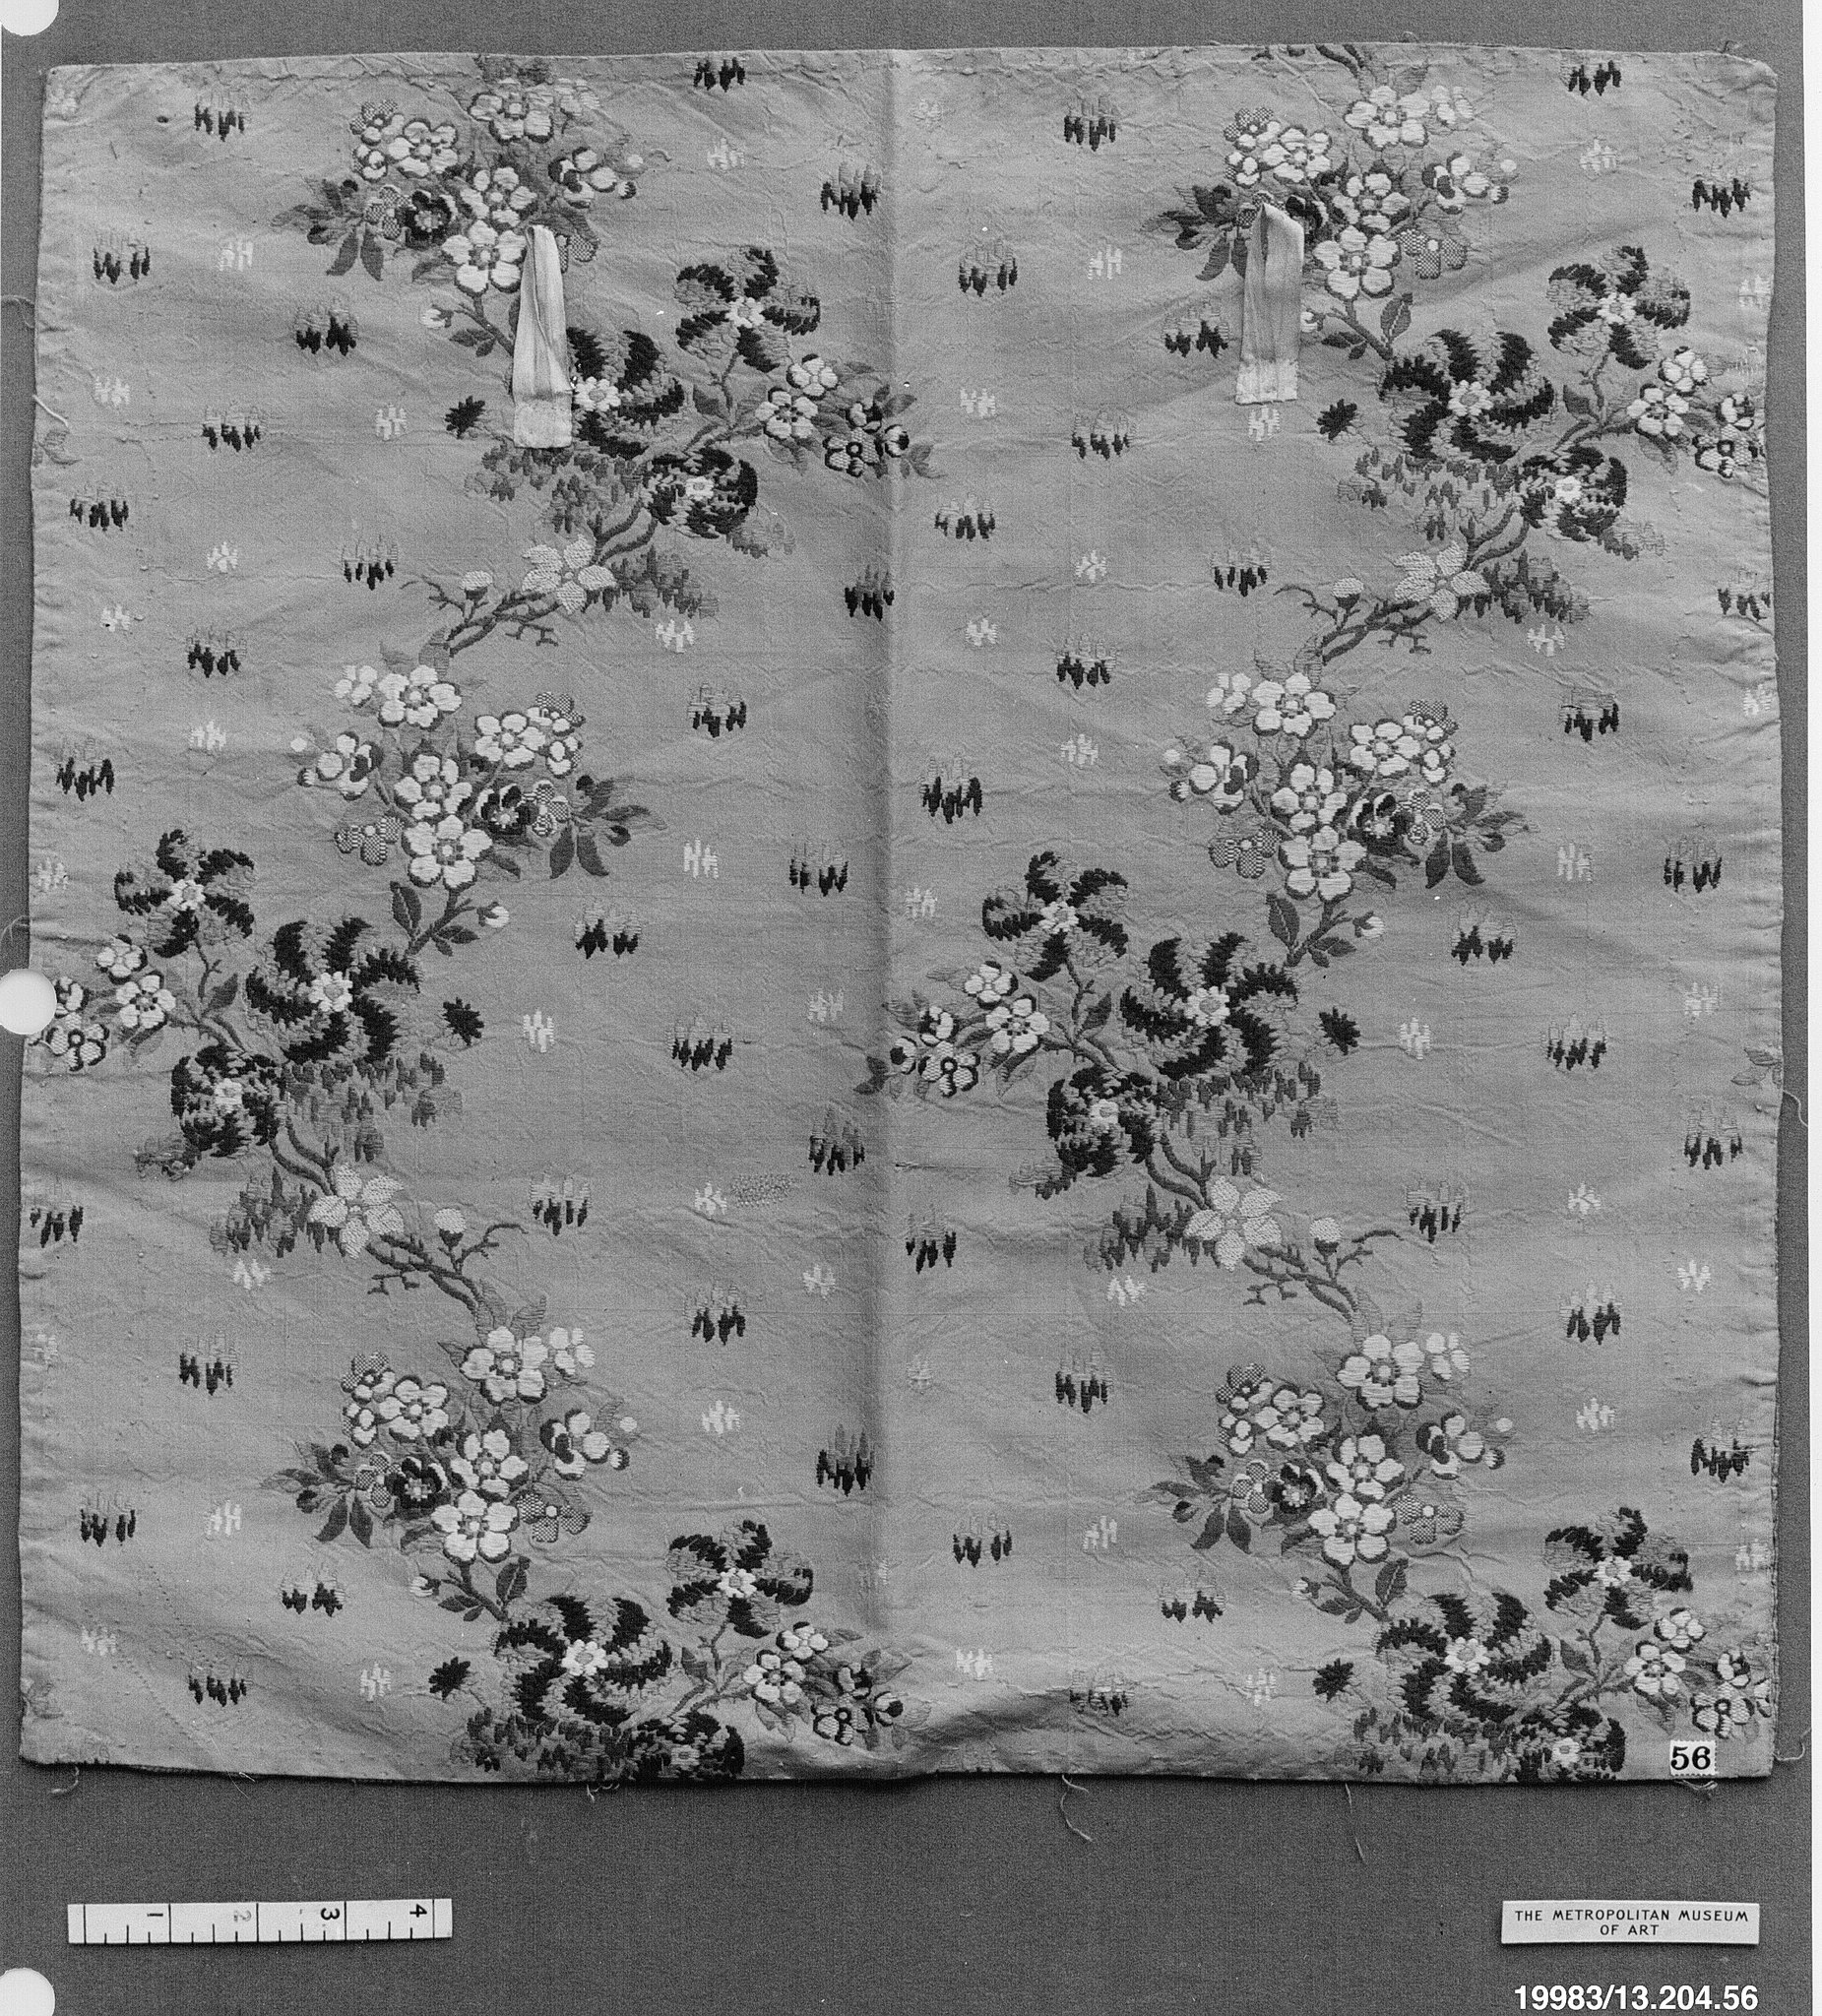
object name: piece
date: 1760-1770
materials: silk